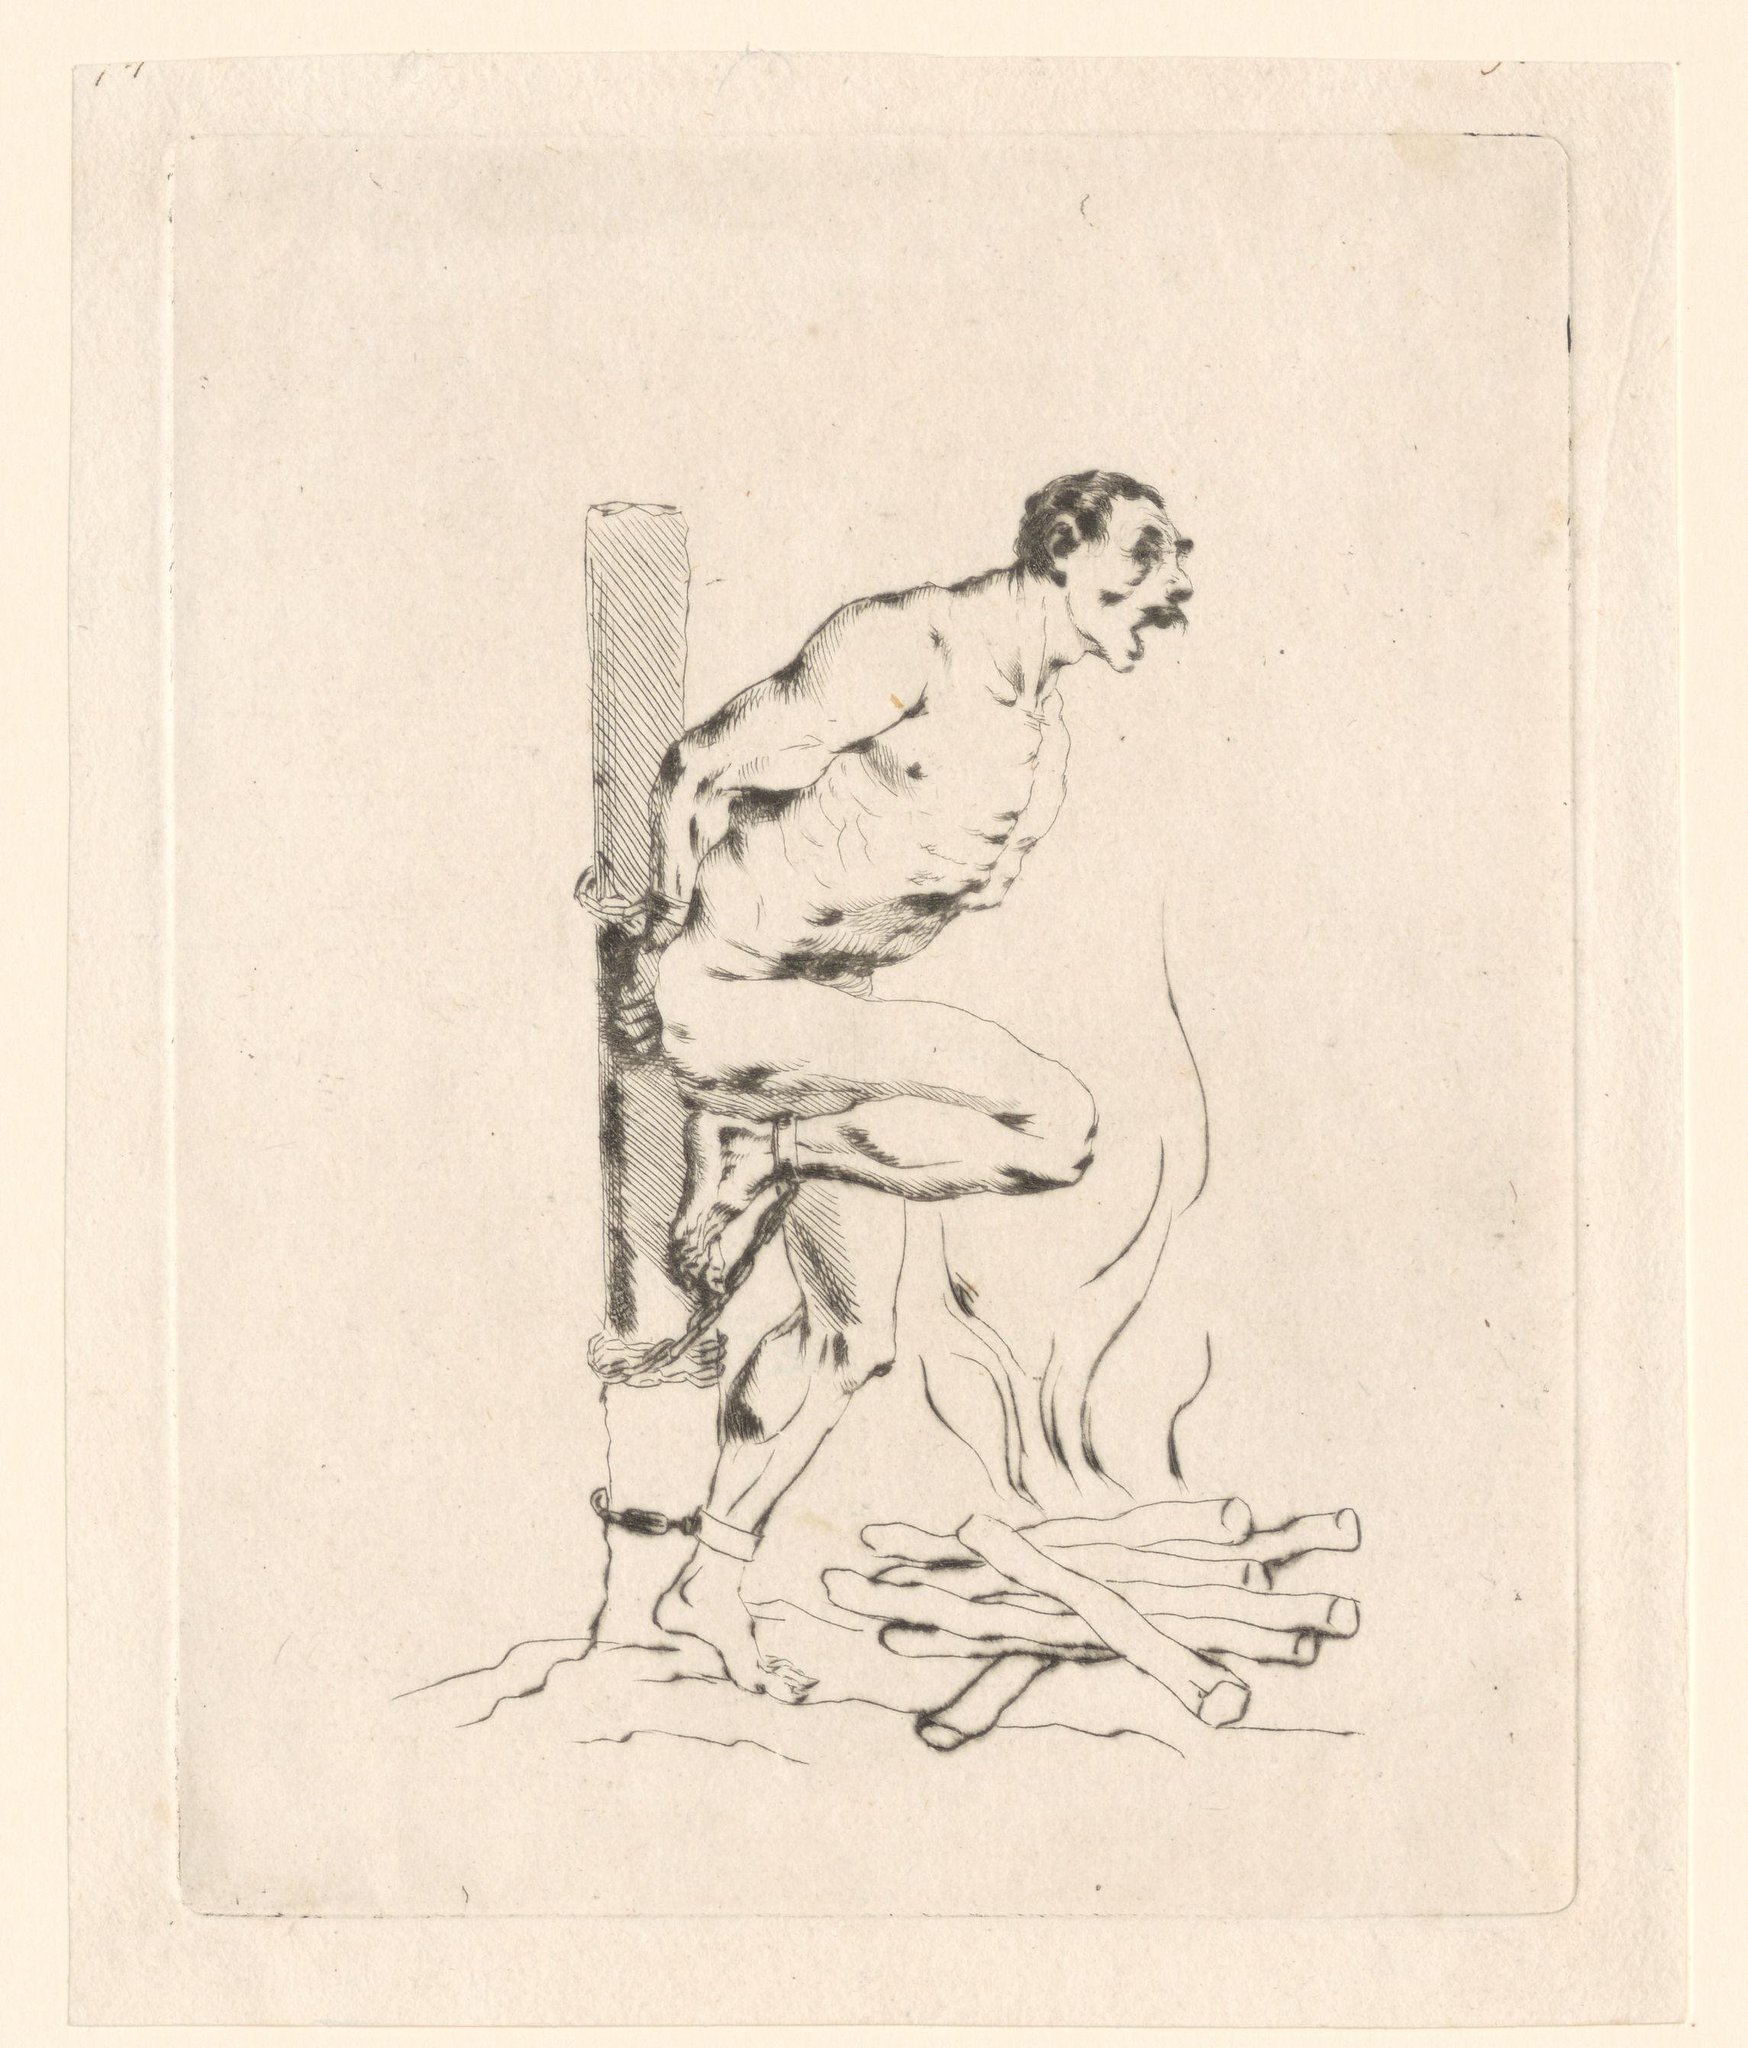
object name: print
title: Naakte man vastgebonden boven brandstapel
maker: thomas worlidge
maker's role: print maker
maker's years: 1700-1766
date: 1710-1766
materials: paper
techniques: drypoint, etching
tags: violent death by having part of the boy tortured with fire - ee - death not certain, wounded person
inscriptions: collector's mark: Lugt 2760, collector's mark: Lugt 2228